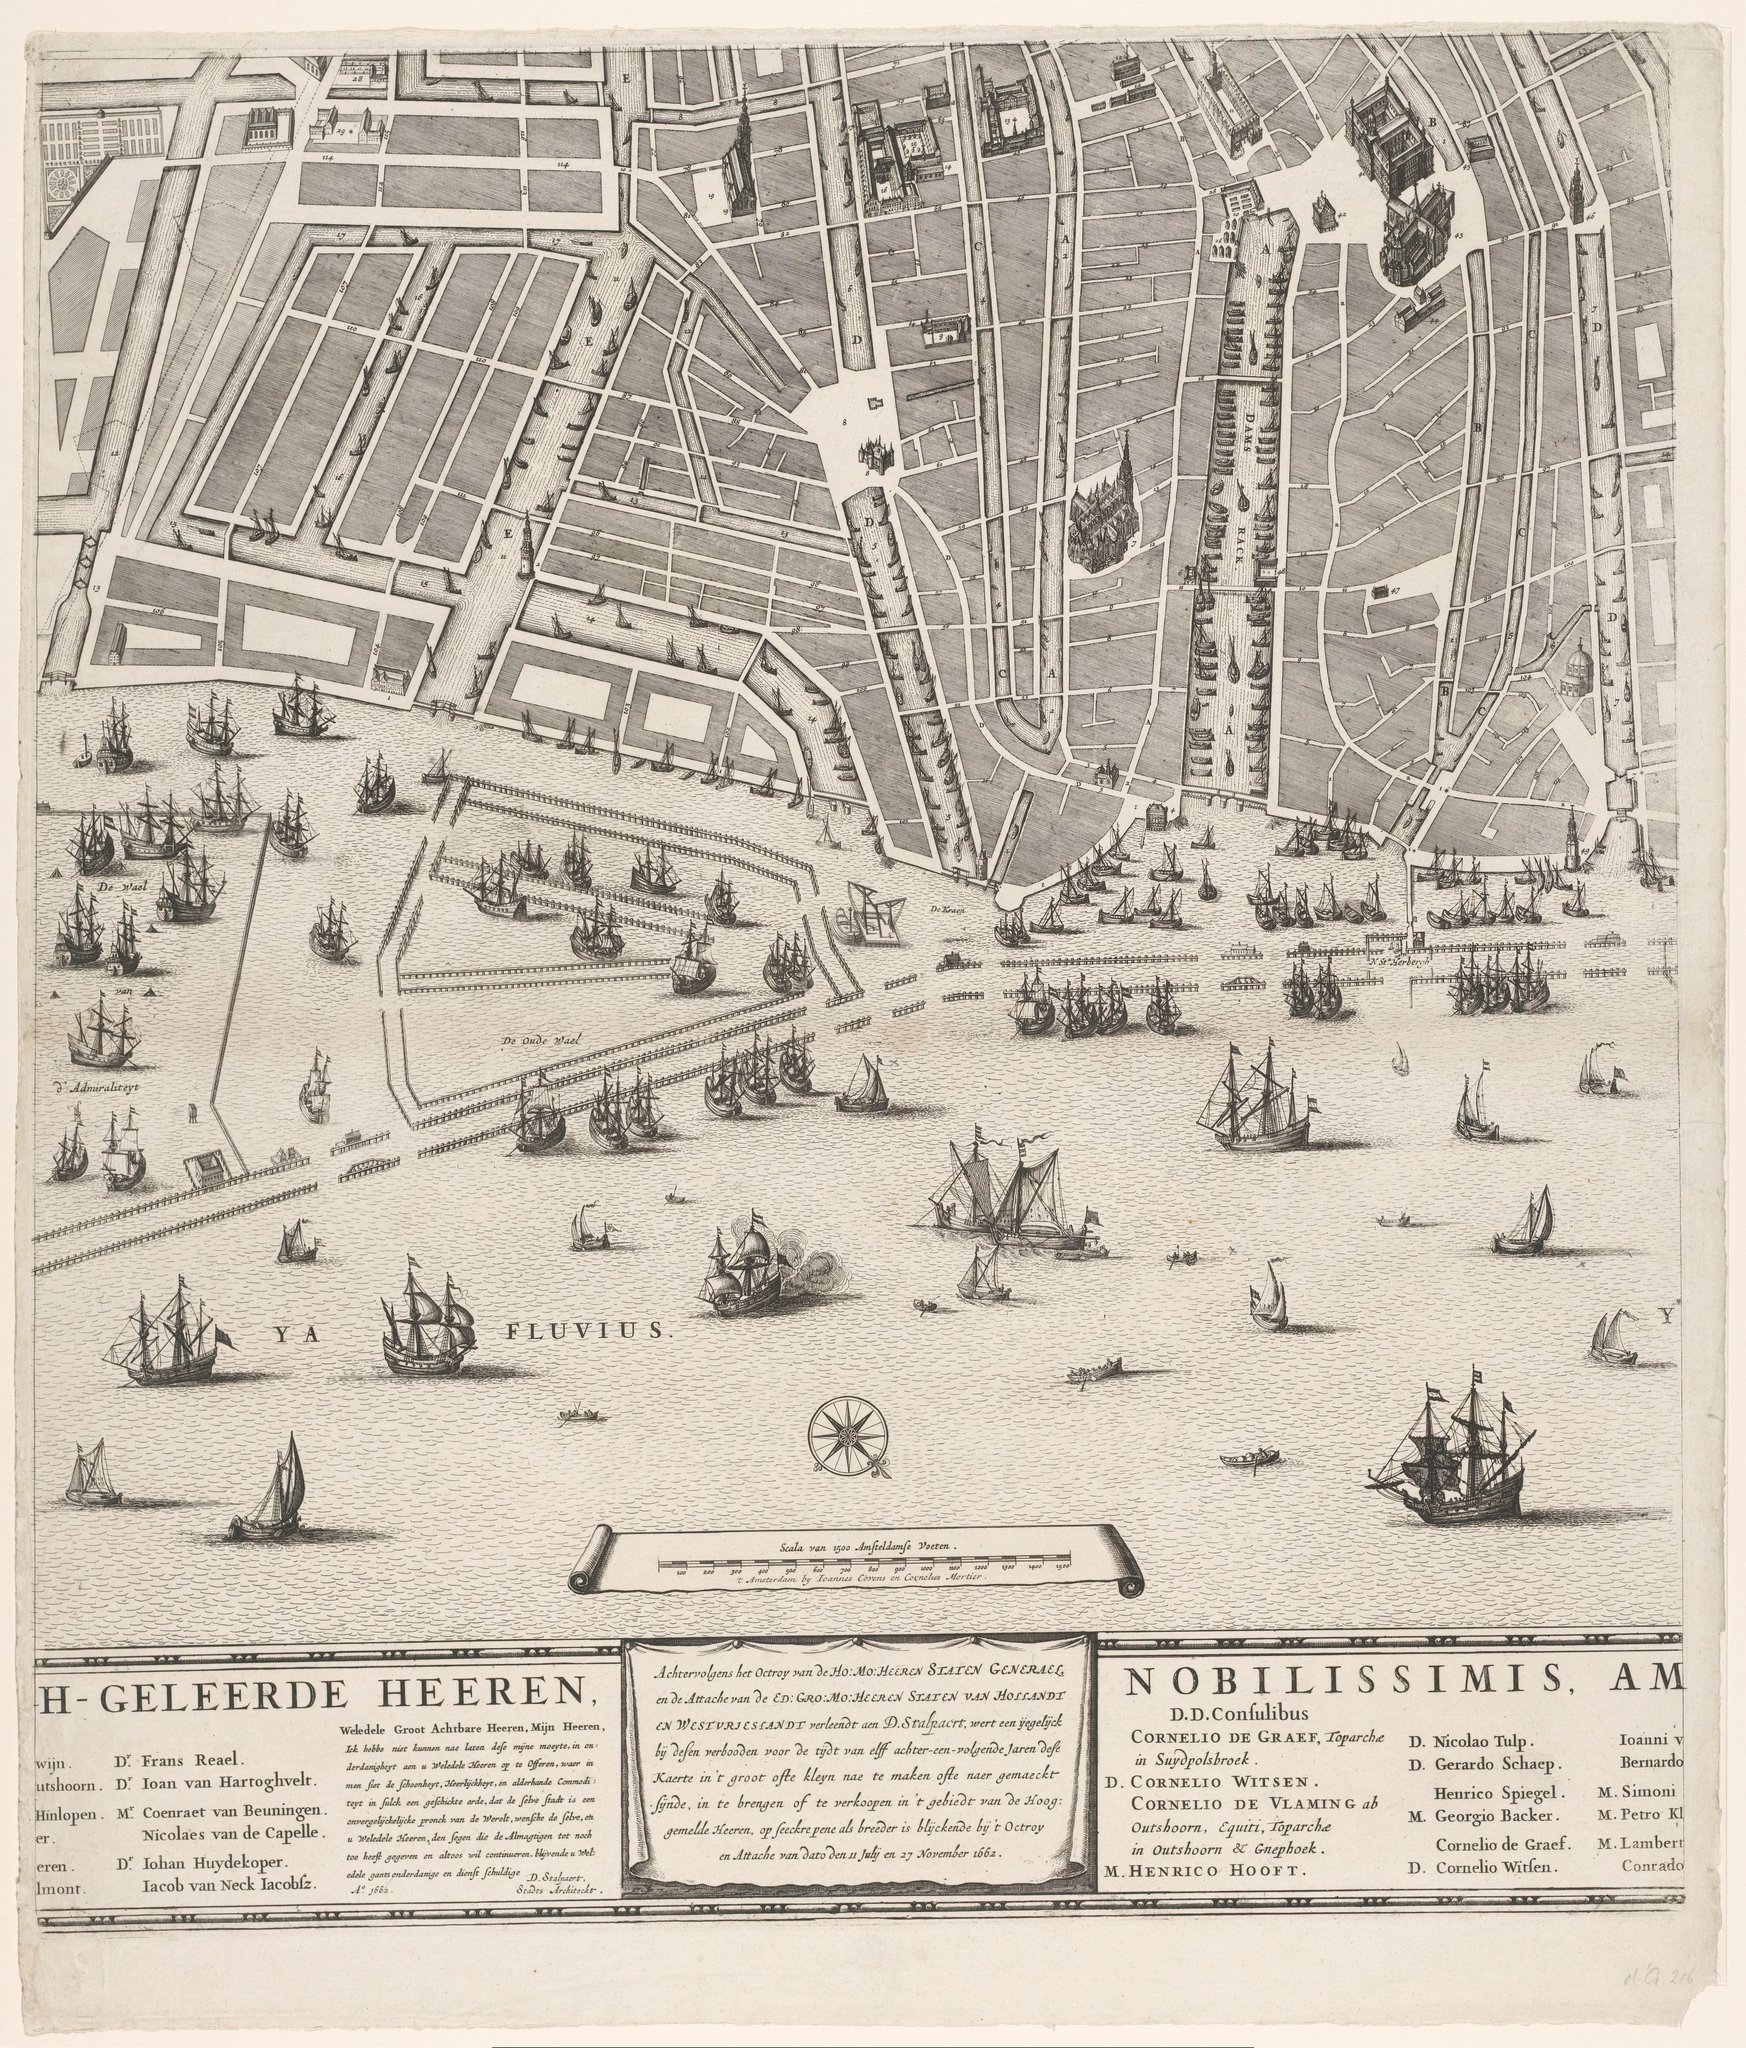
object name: area plan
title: Plattegrond van Amsterdam met ontwerp en uitvoering van de Vierde Uitleg (vijfde deel)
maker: julius mülhüssen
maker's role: draughtsman, print maker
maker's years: 1611-1680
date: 1601-1663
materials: paper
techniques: engraving, etching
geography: amsterdam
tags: maps of cities, amsterdam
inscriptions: collector's mark: Lugt 195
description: Vijfde deel van een plattegrond van Amsterdam met ontwerp en uitvoering van de Vierde Uitleg, bestaande uit zes delen. Geen nummering (meer) zichtbaar.